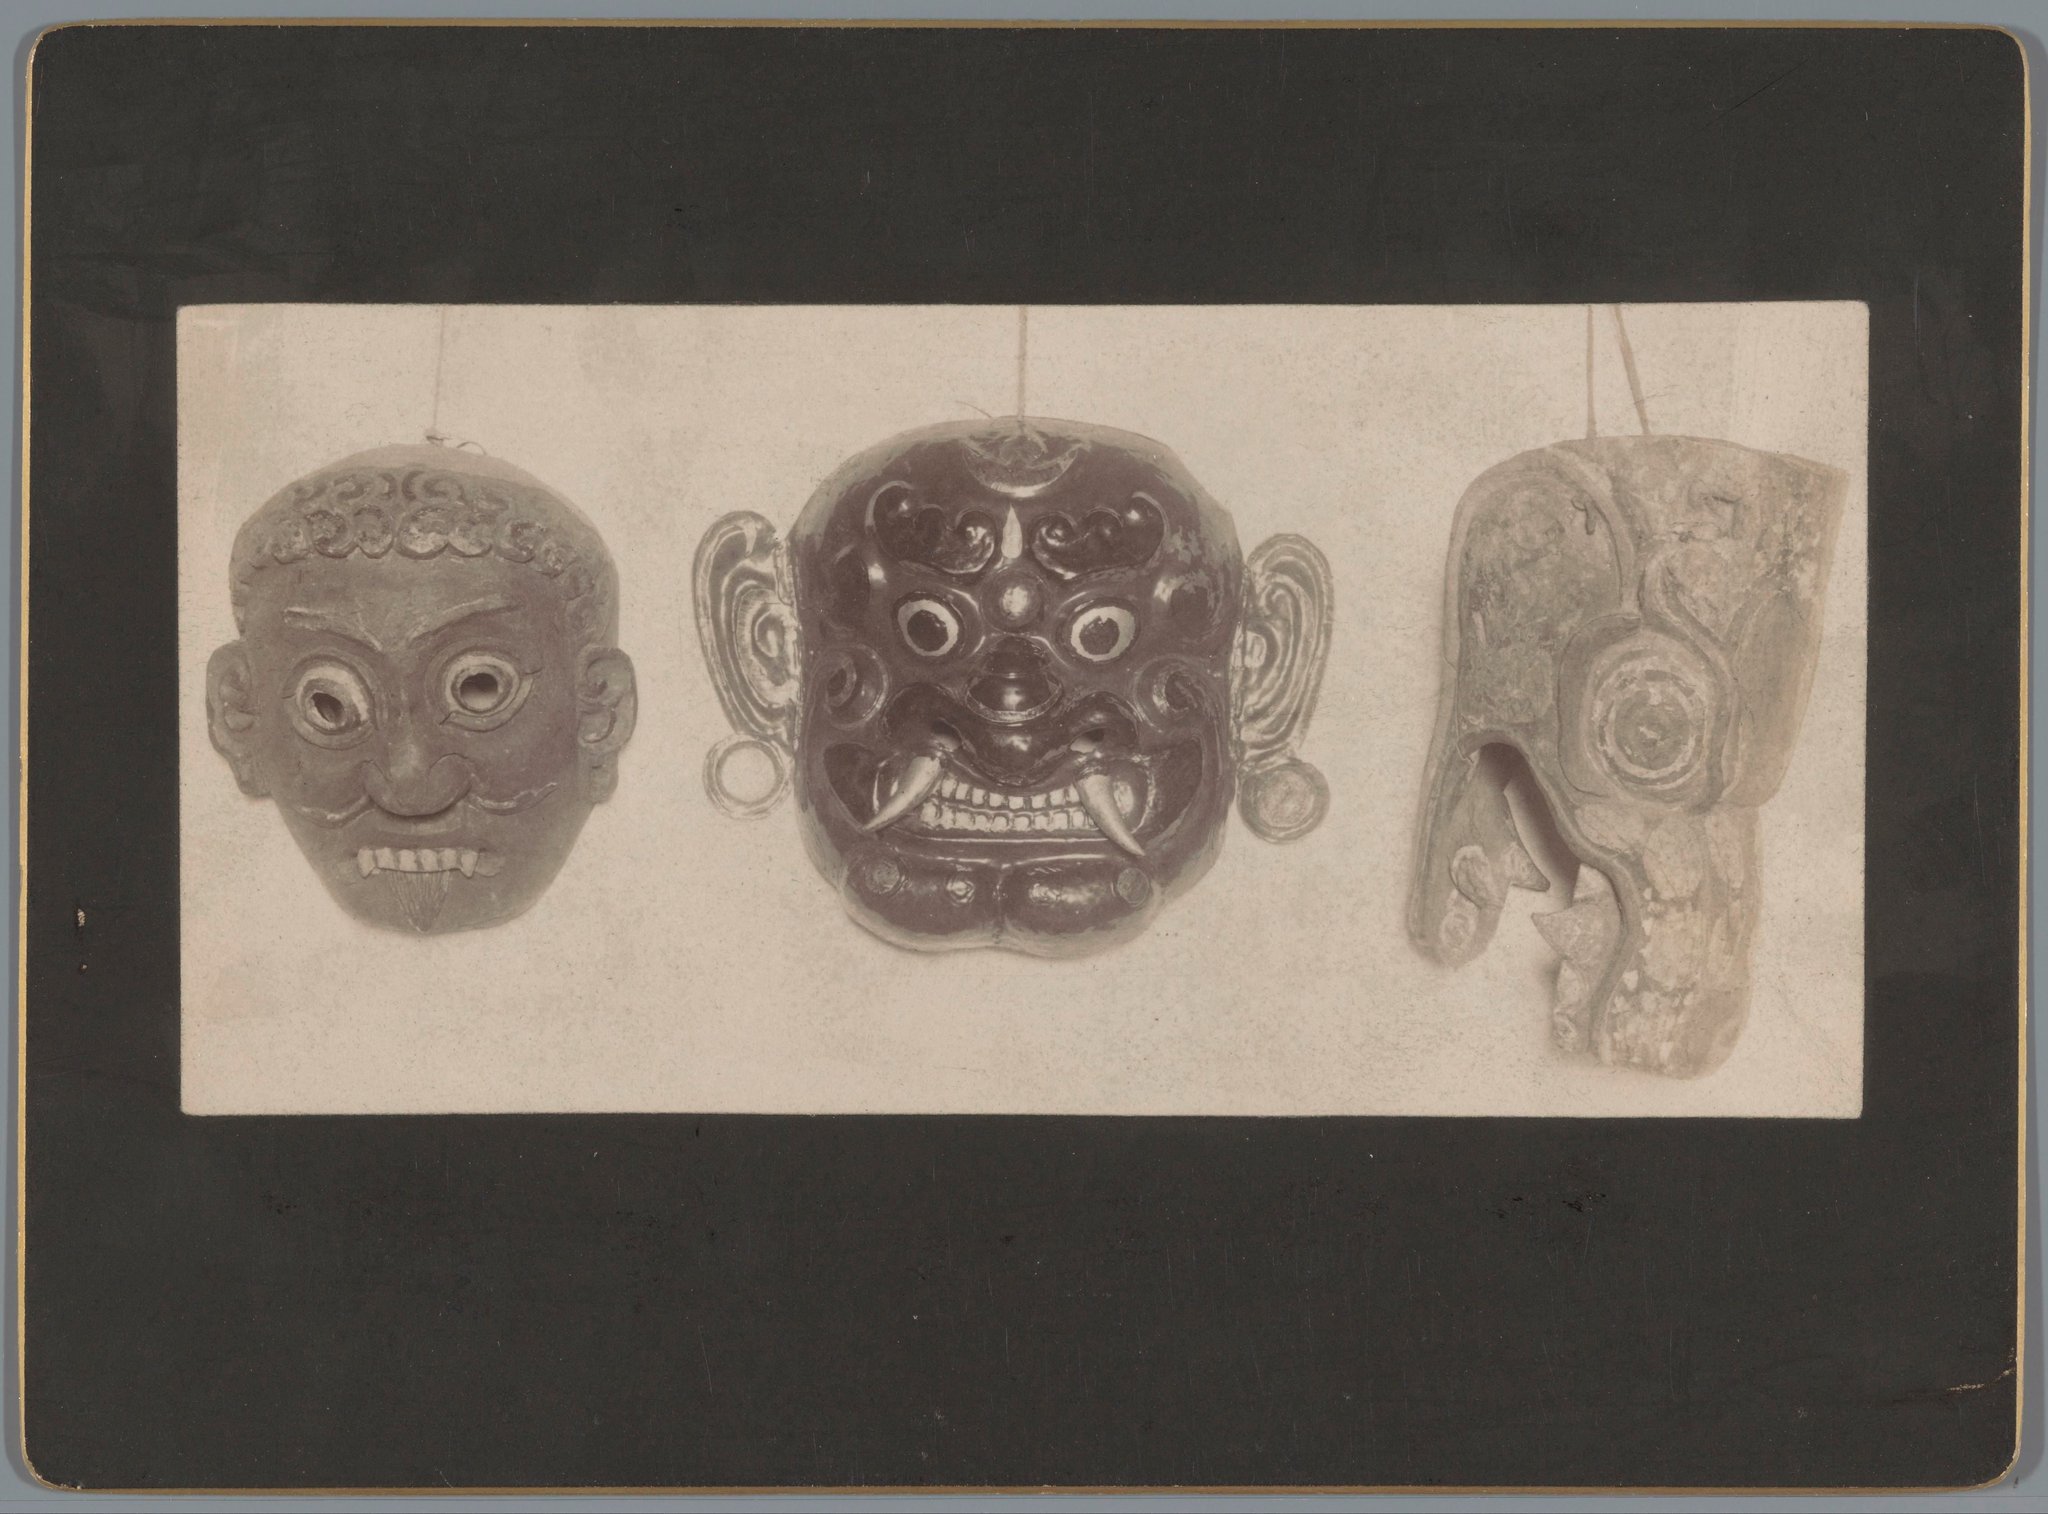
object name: photograph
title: Maskers voor den duivelsdans, Thibet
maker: Anonymous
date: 1897-1910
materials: cardboard, paper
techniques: albumen print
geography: rijks ethnographisch museum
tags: mask